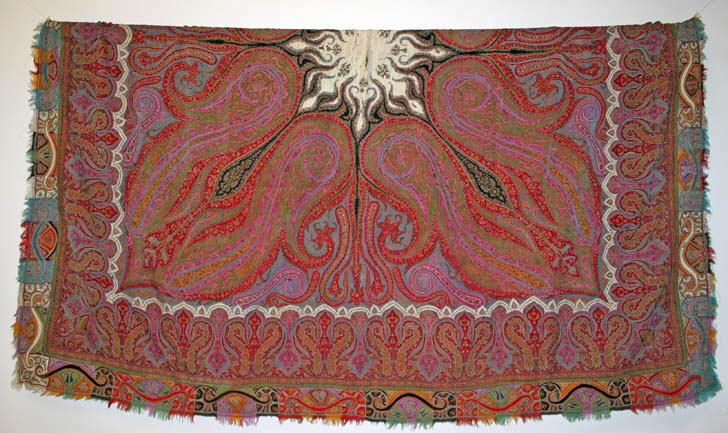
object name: shawl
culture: indian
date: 1834-1866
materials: wool